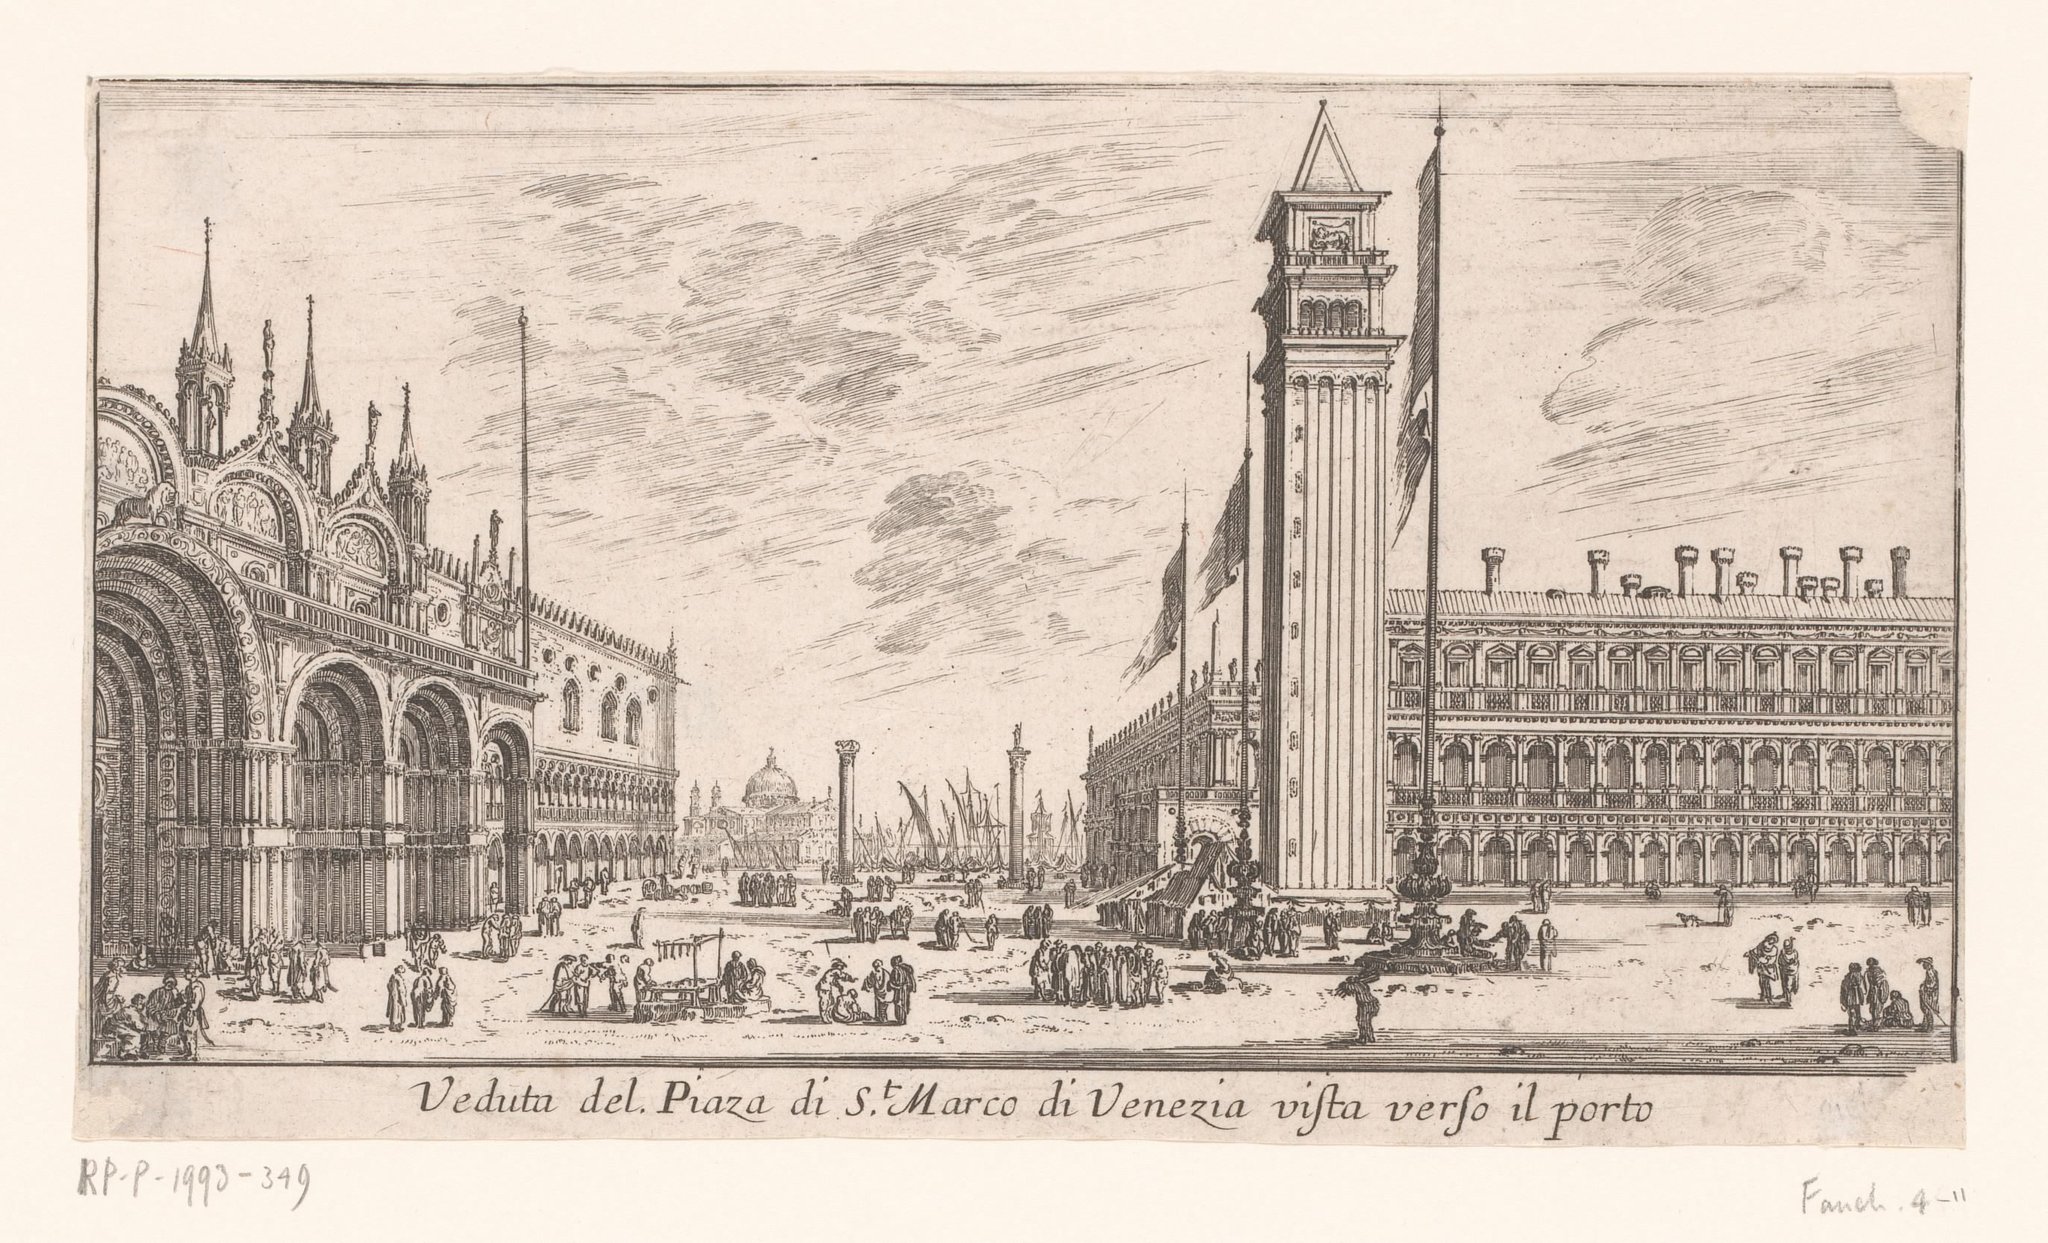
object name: print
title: Vues de Rome et de Venise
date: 1636-1691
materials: paper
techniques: engraving, etching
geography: france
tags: city-view in general; 'veduta'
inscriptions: collector's mark: Lugt 2228